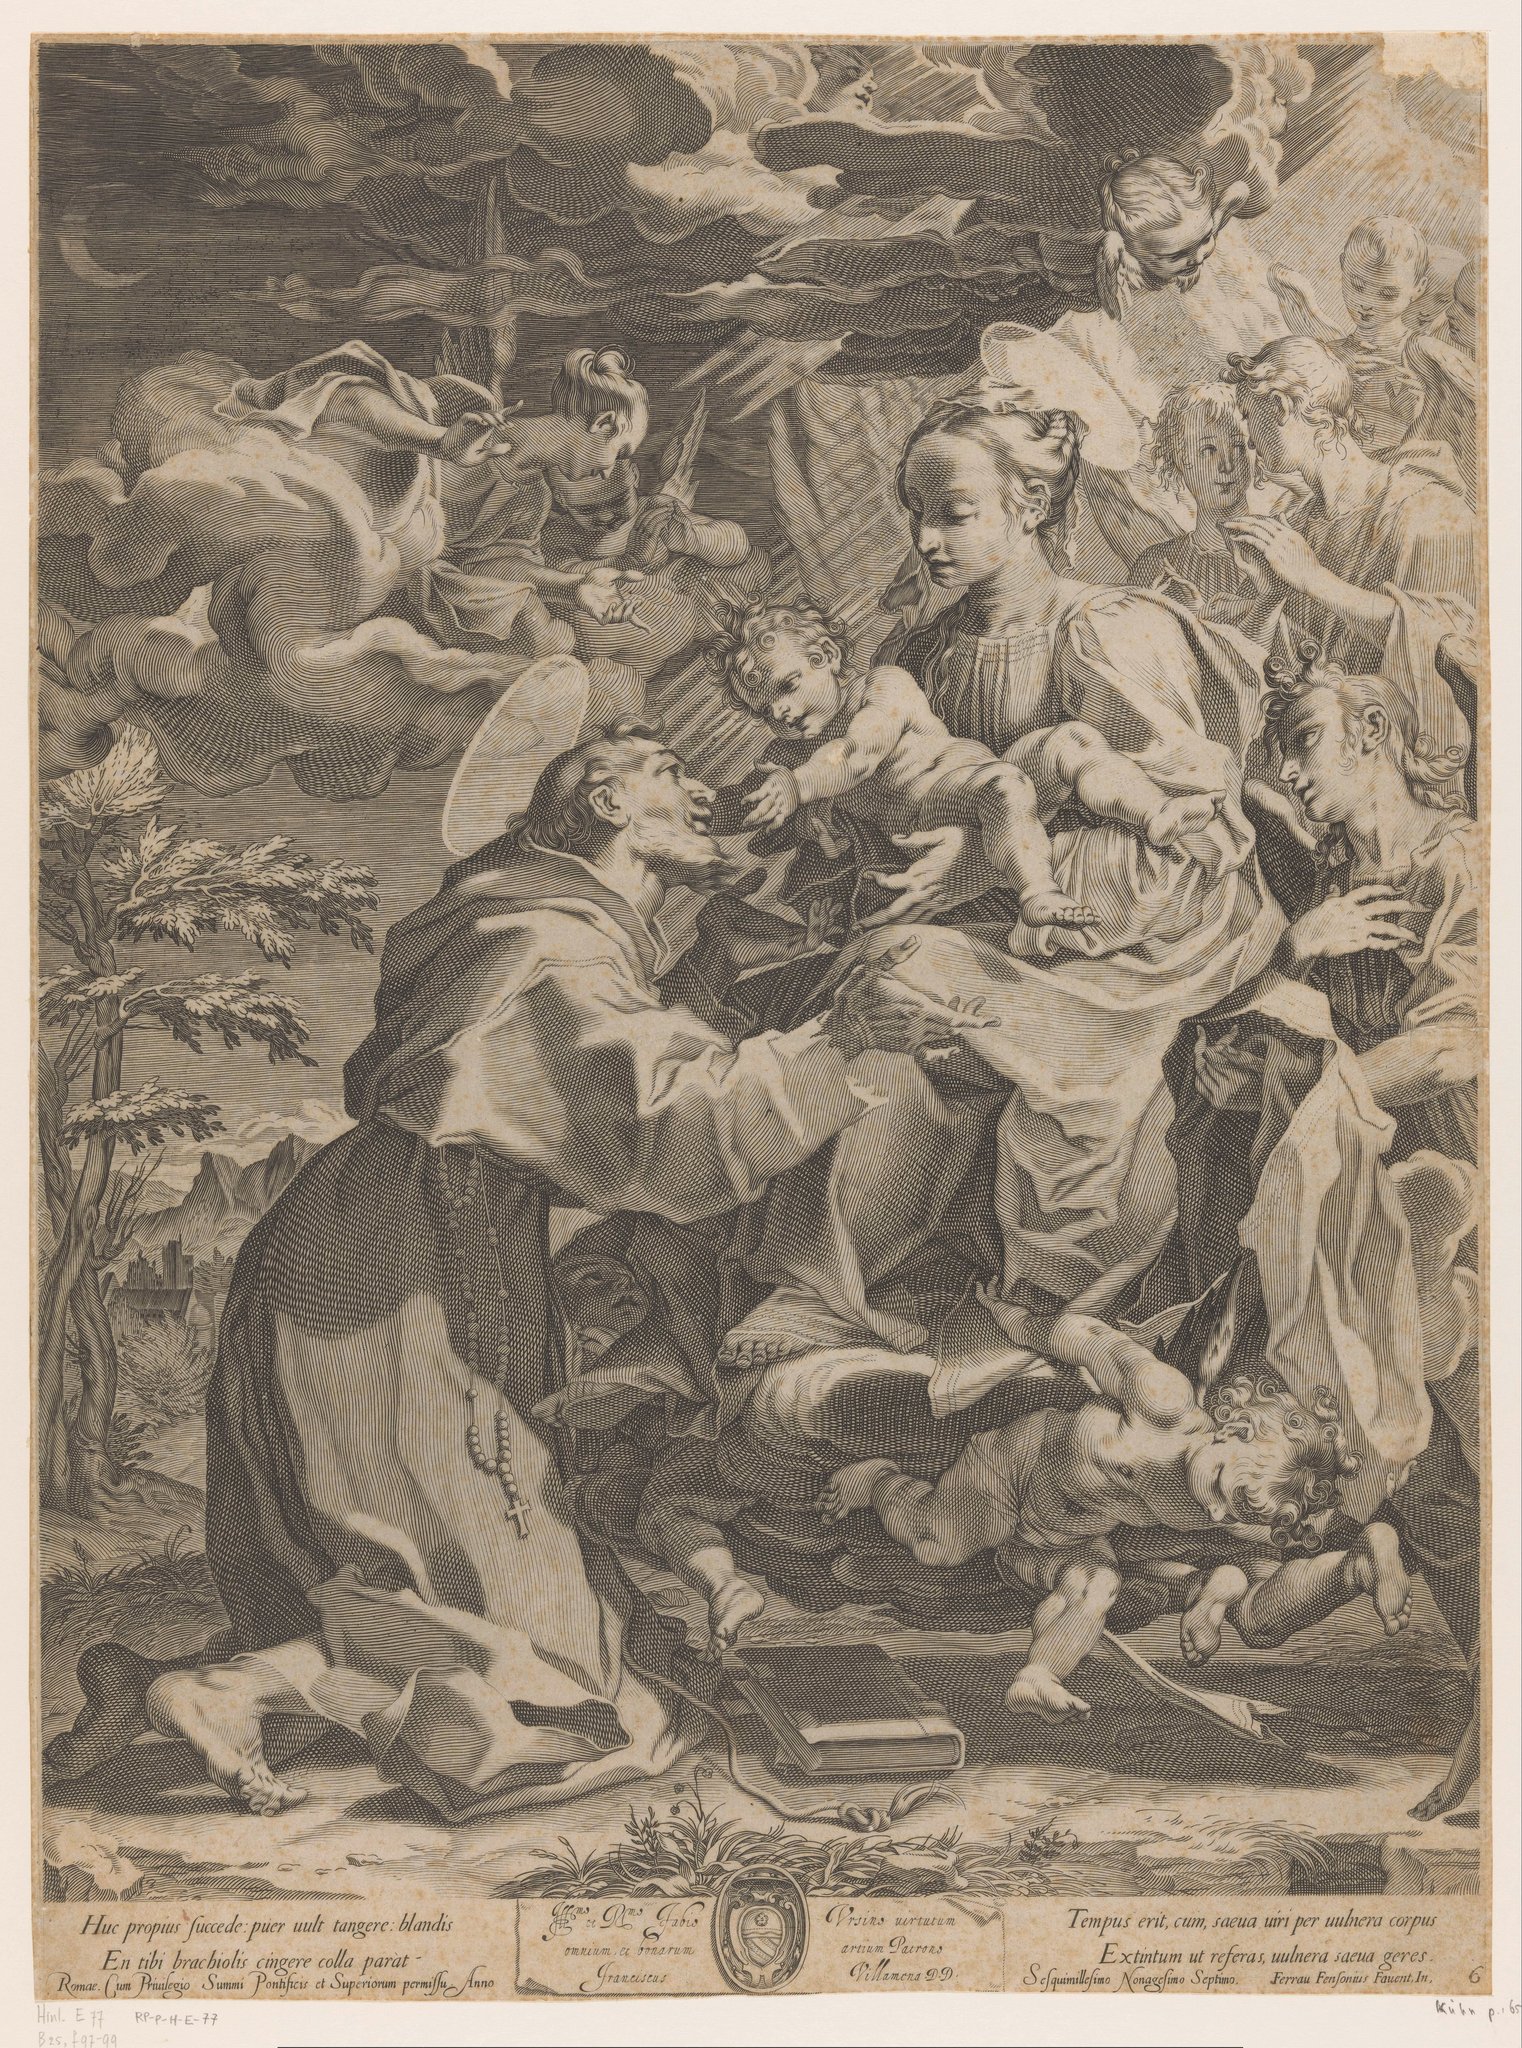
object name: print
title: Maria overhandigt het Christuskind aan Franciscus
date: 1597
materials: paper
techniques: engraving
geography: vatican city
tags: cherubs, i.e. children's heads with wings, angels, the virgin mary handing over the infant christ to st. francis of assisi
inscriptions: collector's mark: ‘Hinloopen’, collector's mark: Lugt 11, collector's mark: Lugt 10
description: Te midden van engelen overhandigt Maria het Christuskind aan de knielende heilige Franciscus van Assisi. Op de grond ligt een boek. Opdracht, wapenschild en Latijnse tekst in twee kolommen in ondermarge.